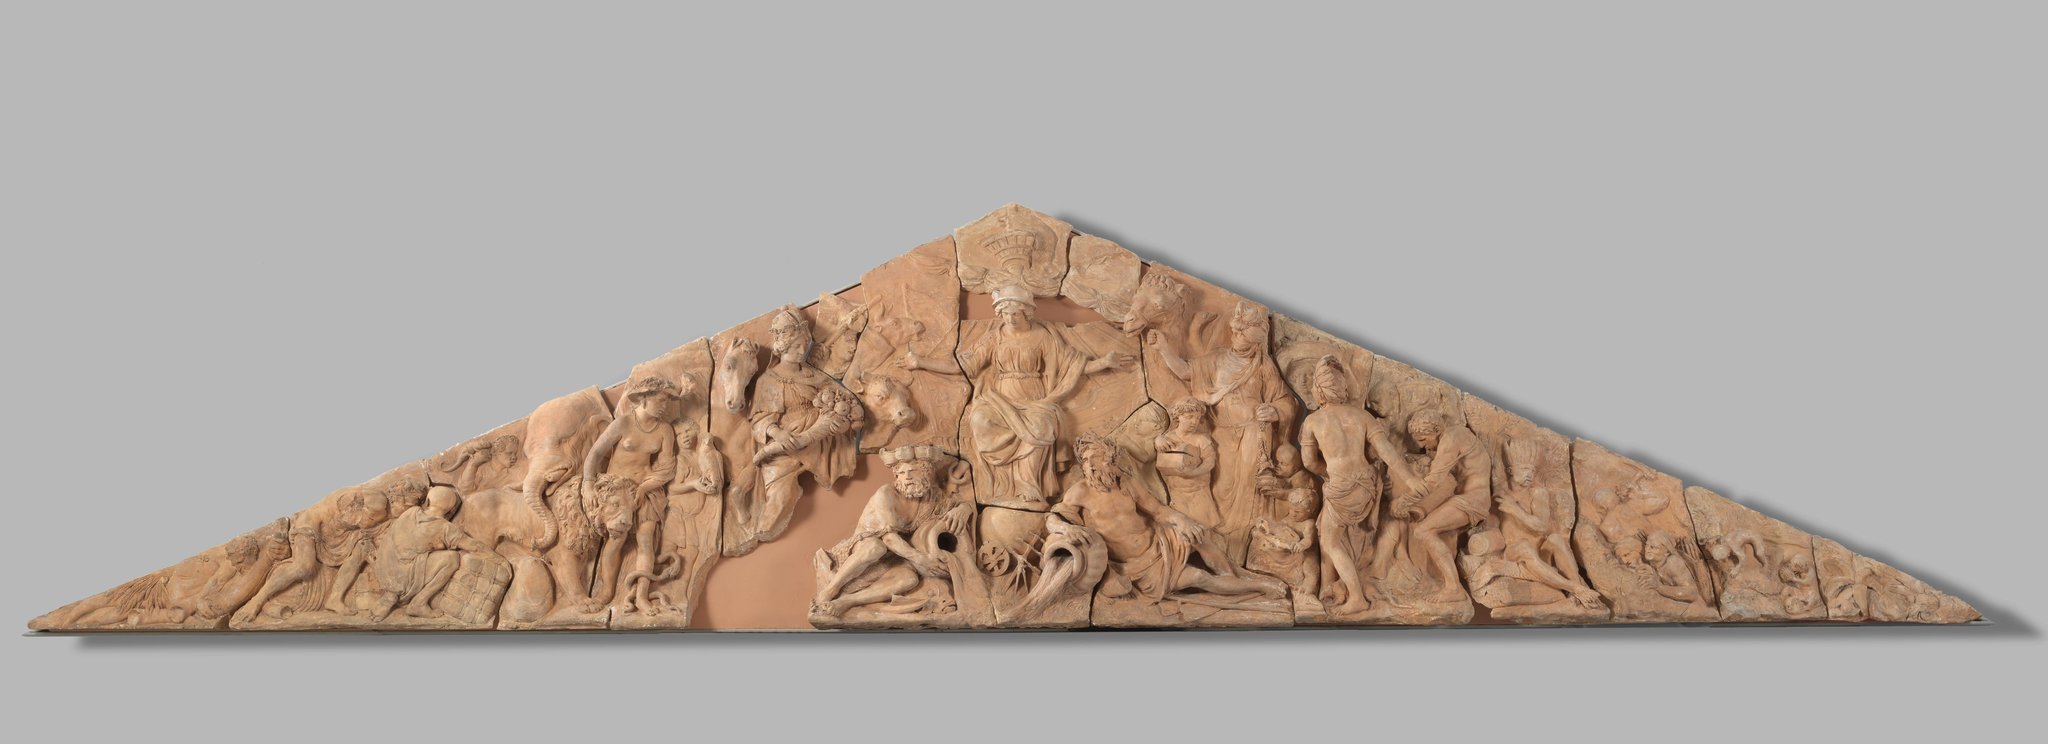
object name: model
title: The Four Continents Bringing Tribute to Amsterdam: Model for the West Tympanum of the Amsterdam Town Hall (now Royal Palace) at Dam Square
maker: artus quellinus (i)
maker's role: draughtsman, print maker, sculptor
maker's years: 1609-1668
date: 1650-1653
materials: terracotta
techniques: modeling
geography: amsterdam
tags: europe represented allegorically; 'europa' (ripa), asia represented allegorically; 'asia' (ripa), africa represented allegorically; 'africa' (ripa), personification of a city, town-patron(ess), america represented allegorically; 'america' (ripa), river personified, 'fiumi' (ripa), amsterdam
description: The front and rear elevation of the Town Hall are each dominated by a sculpted marble tympanum approximately twenty metres in width and surmounted by bronze statues. This design for the rear façade shows the four (then known) continents bringing prosperity to Amsterdam. It symbolizes the Amsterdam merchants’ worldwide trading network.